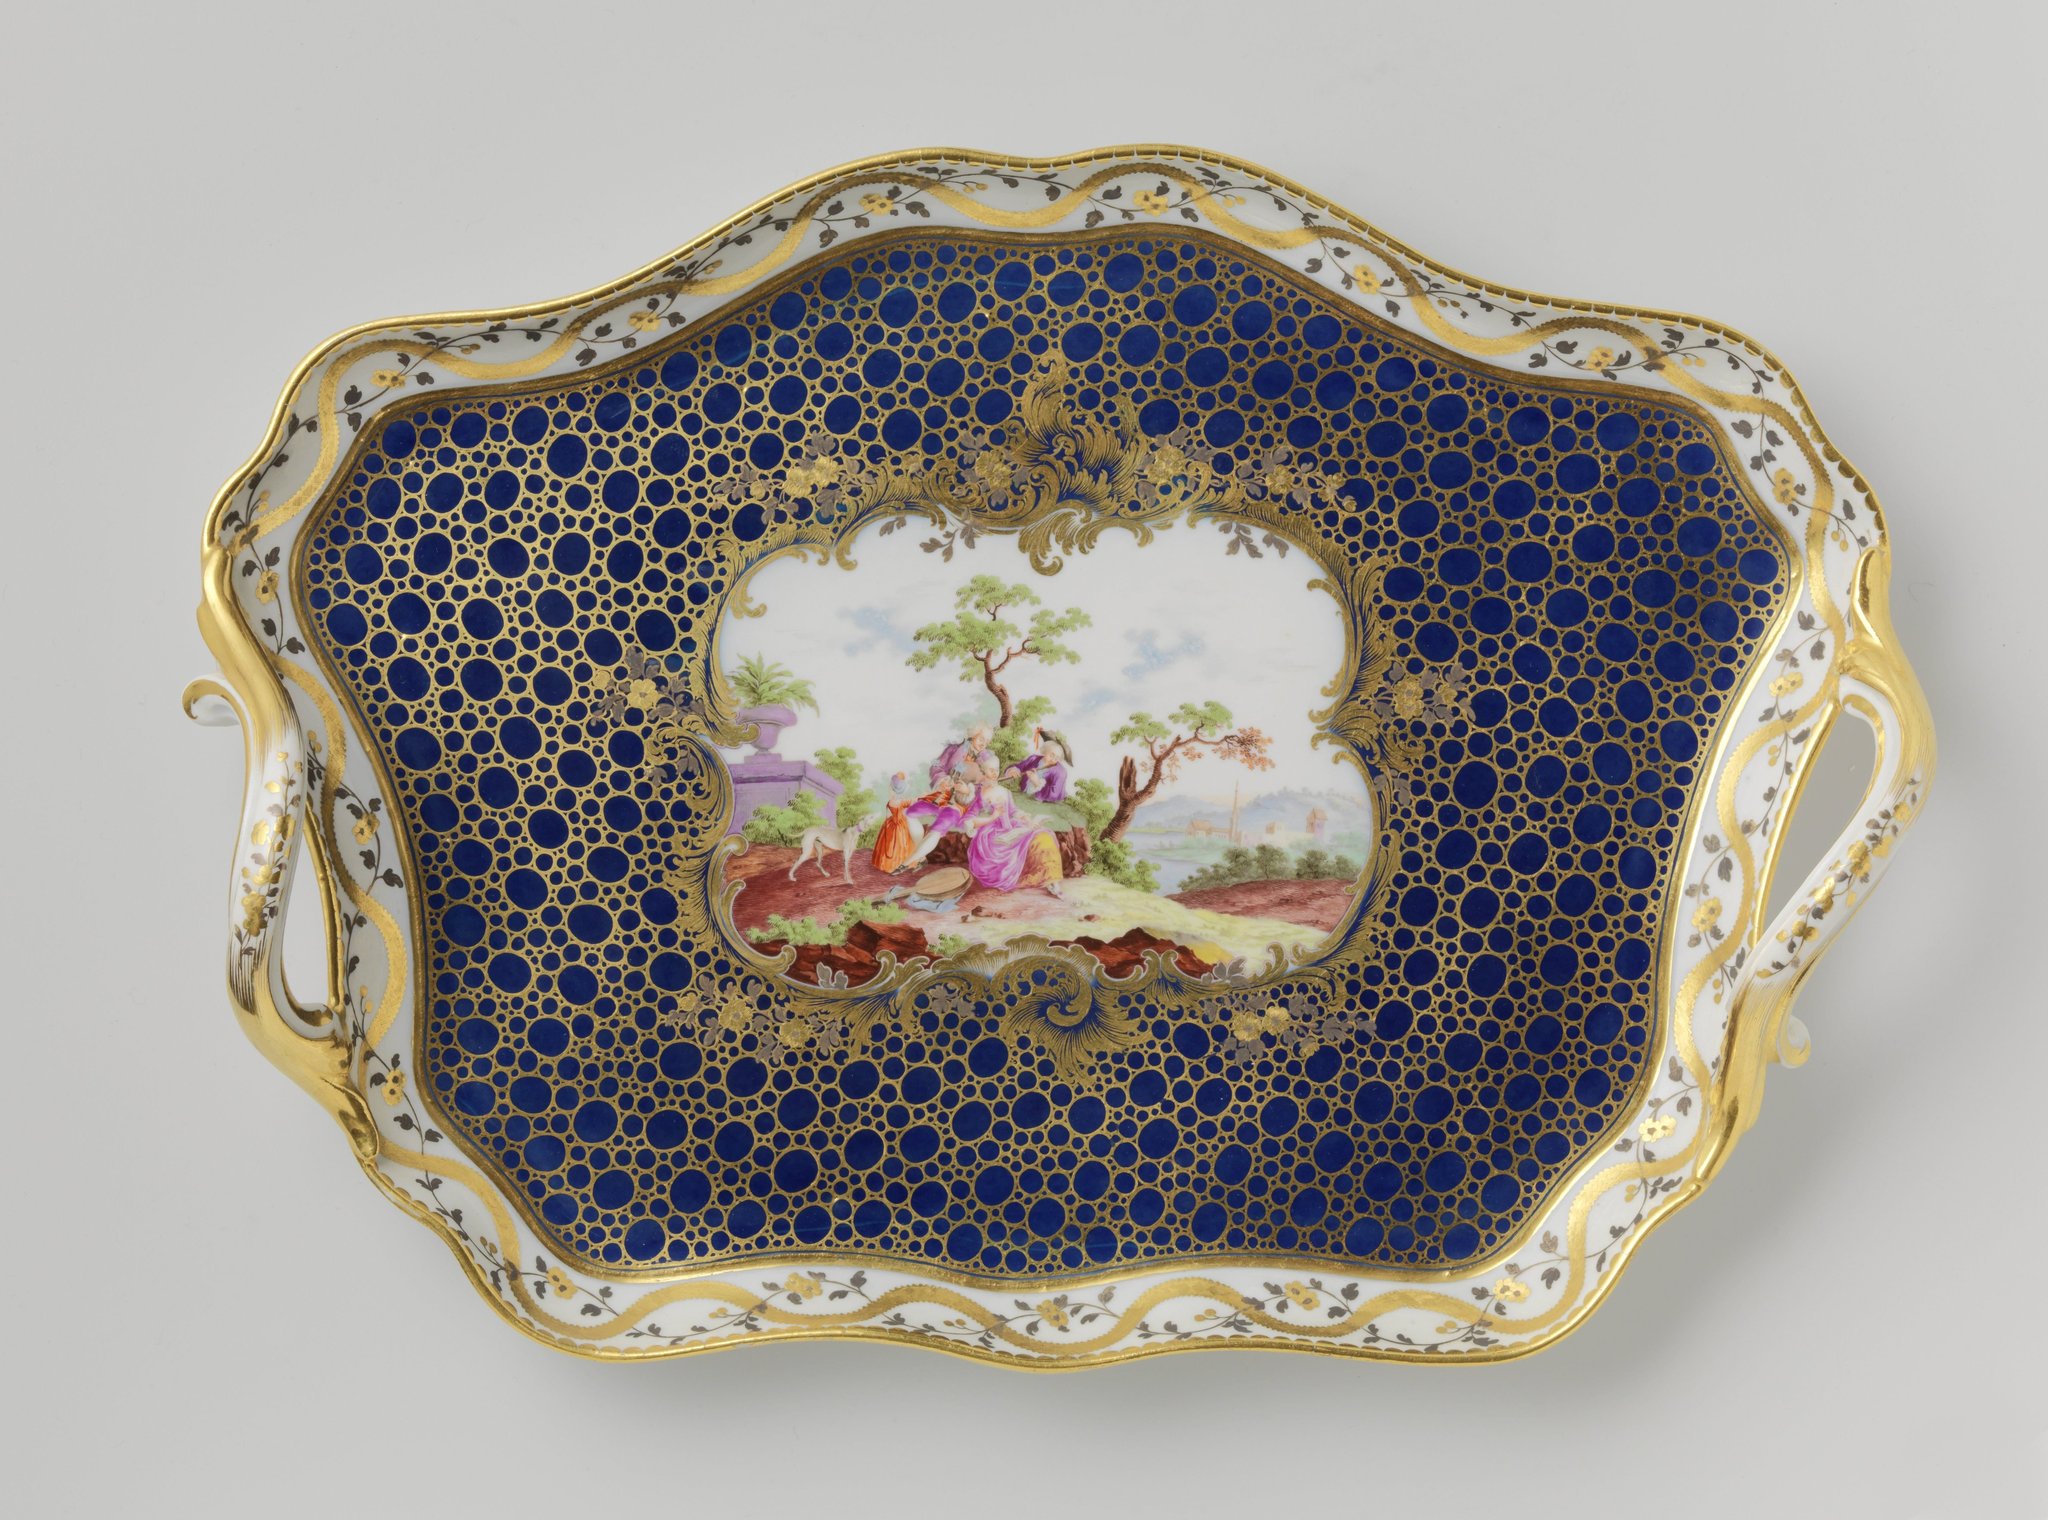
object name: blad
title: Tray with a group in a landscape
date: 1765-1770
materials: glaze, gold, paint, porcelain, silver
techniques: firing, gilding, turning, vitrification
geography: vienna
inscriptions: mark: ‘schild/ E’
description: Waaiervormig blad van porselein met gelobde wand en rand en twee handvaten. Beschilderd op het glauur in emailkleuren, zilver[?] en goud. Het blad is op de voorzijde bedekt met blauw waarover in goud een patroon van cirkels is aangebracht. Hierin uitgespaard een rocaille cartouche met daarin een groep musicerende mensen in een landschap, naast hen een meisje en een hond. De binnenwand met bloemranken. Gemerkt op de onderzijde met het schild en de letter E.